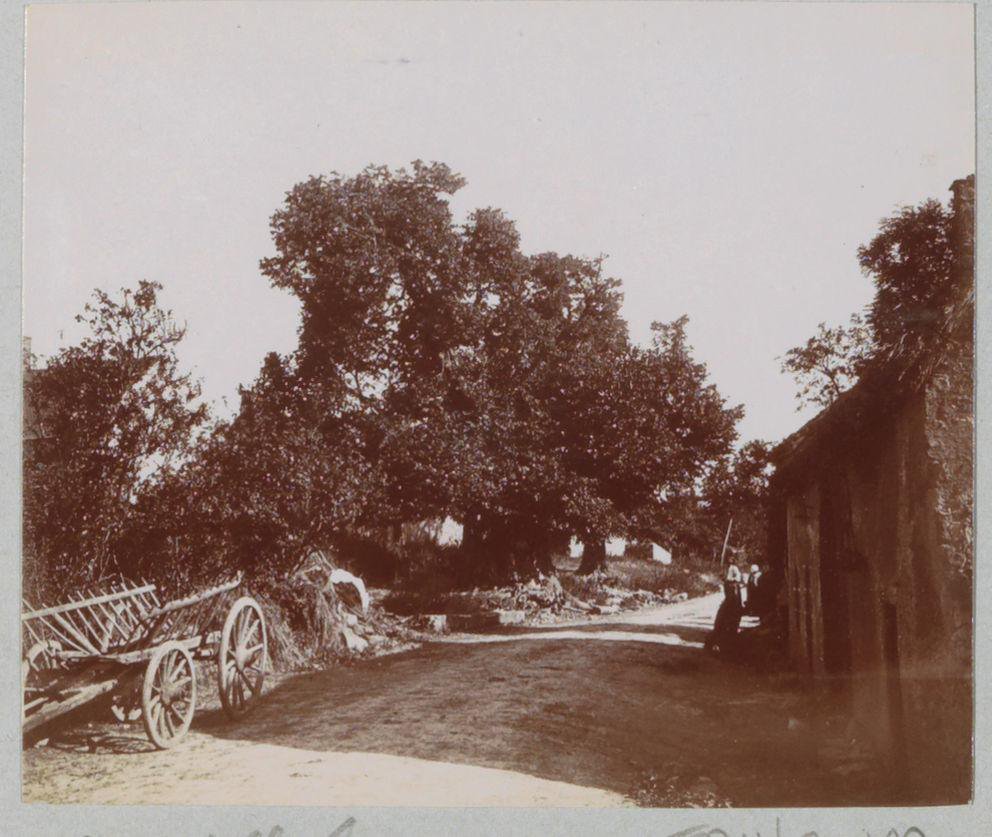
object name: photograph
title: Landweg met oude linde (Gros Tilleul) en hooiwagen in Frankrijk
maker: delizy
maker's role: manufacturer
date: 1904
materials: paper, photographic support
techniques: gelatin silver print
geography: france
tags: prospect of village, silhouette of village, trees, road, path, hay-wagon, france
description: Onderdeel van Fotoalbum van een Franse amateurfotograaf met opnames van uitstapjes in Frankrijk, Spanje, België, Luxemburg en Nederland, de eerste automobielen en autoraces.